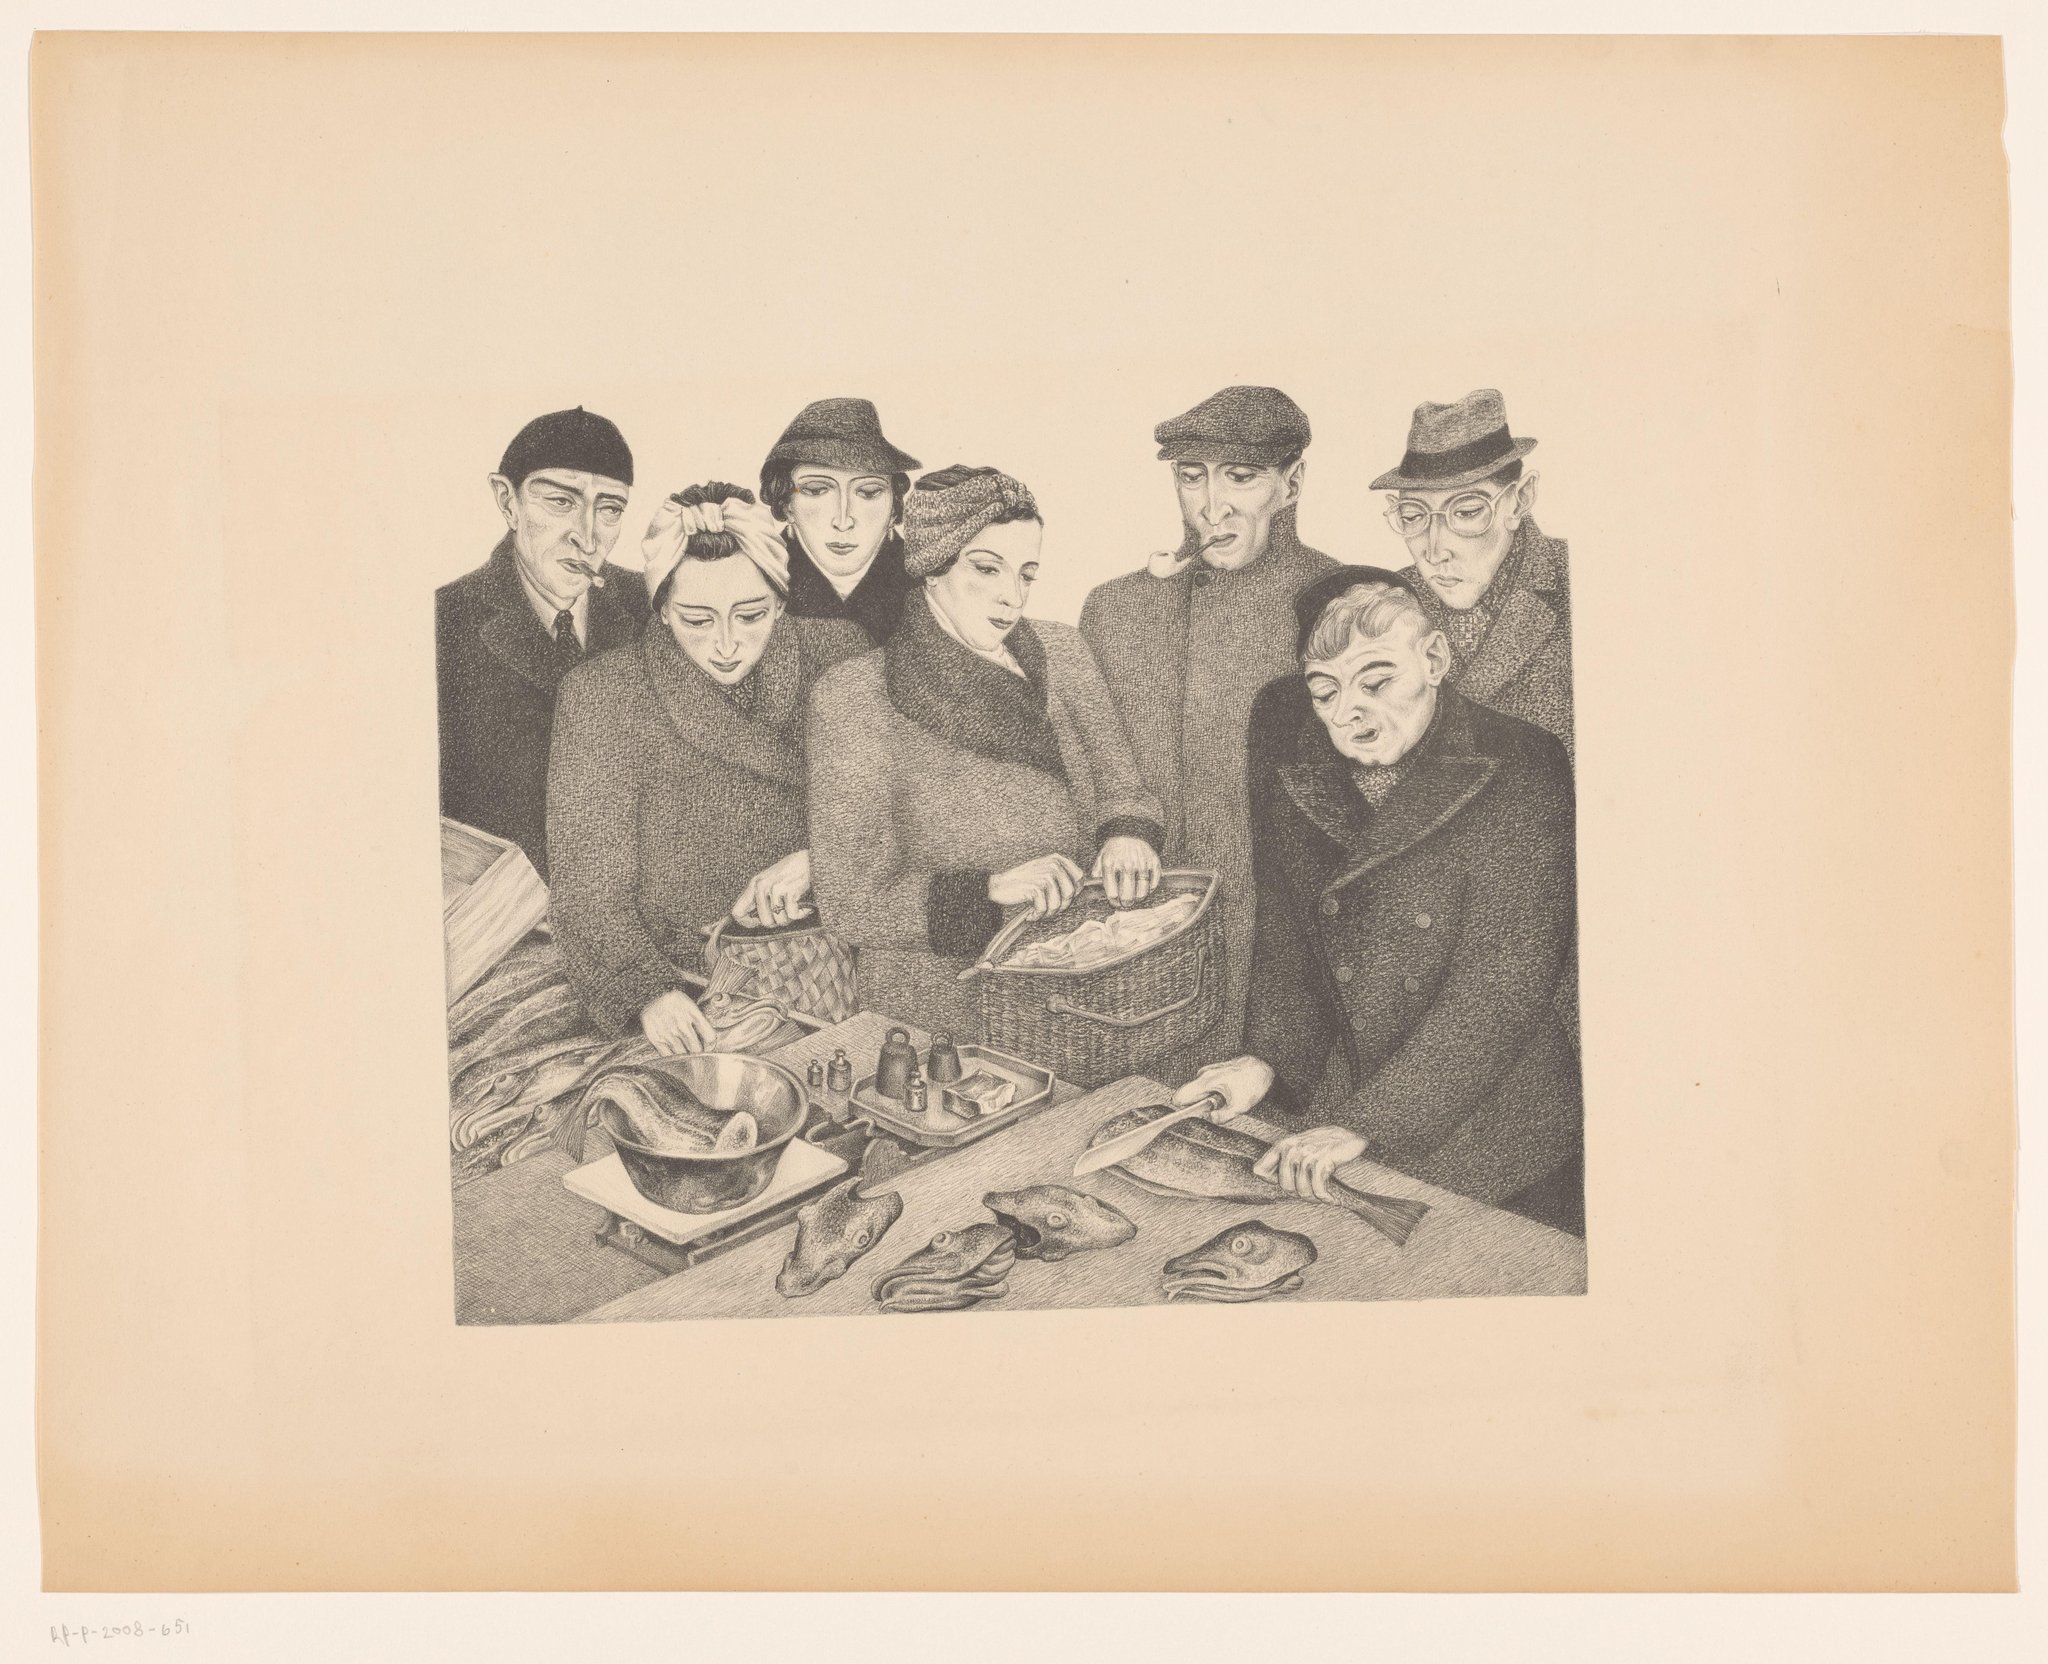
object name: print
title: Viskraam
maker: johan van hell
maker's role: print maker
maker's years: 1889-1952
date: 1948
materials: paper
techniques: lithograph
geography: amsterdam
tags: fishes, stall, booth (~ market), selling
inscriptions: collector's mark: Lugt 2228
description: Een zestal klanten wachten terwijl de visverkoper een vis in stukken snijdt.